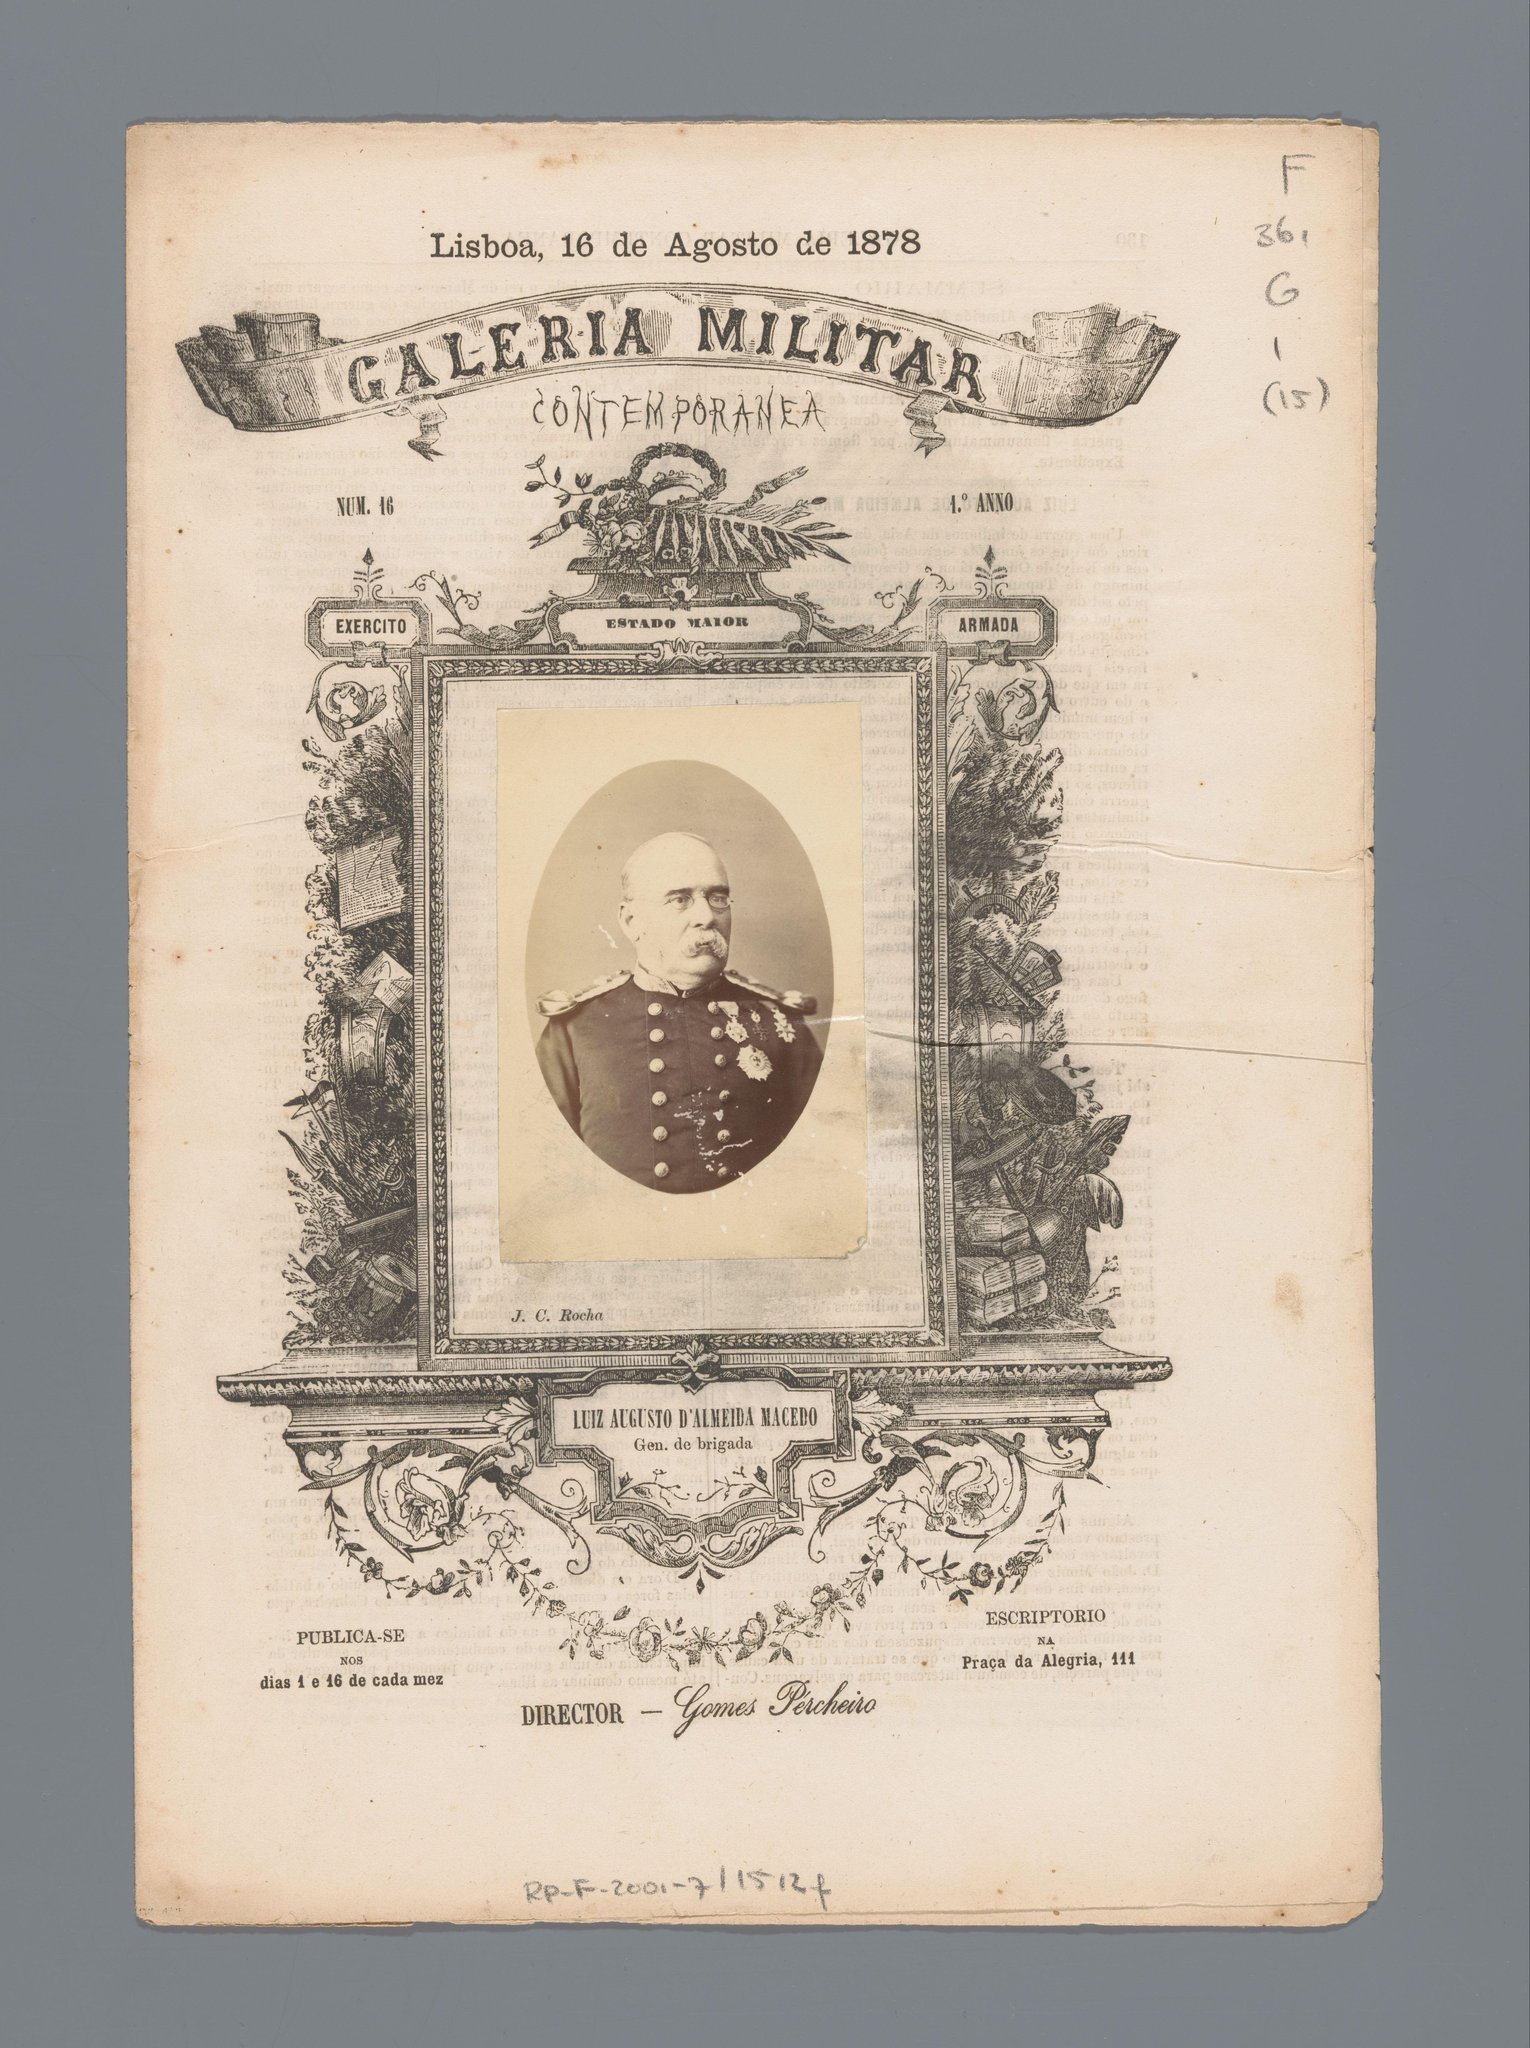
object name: page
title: Portret van Luíz Augusto de Almeida Macedo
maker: j.c. rocha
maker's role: fotograaf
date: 1873-1878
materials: photographic support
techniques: albumen print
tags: historical persons, commander-in-chief, admiral